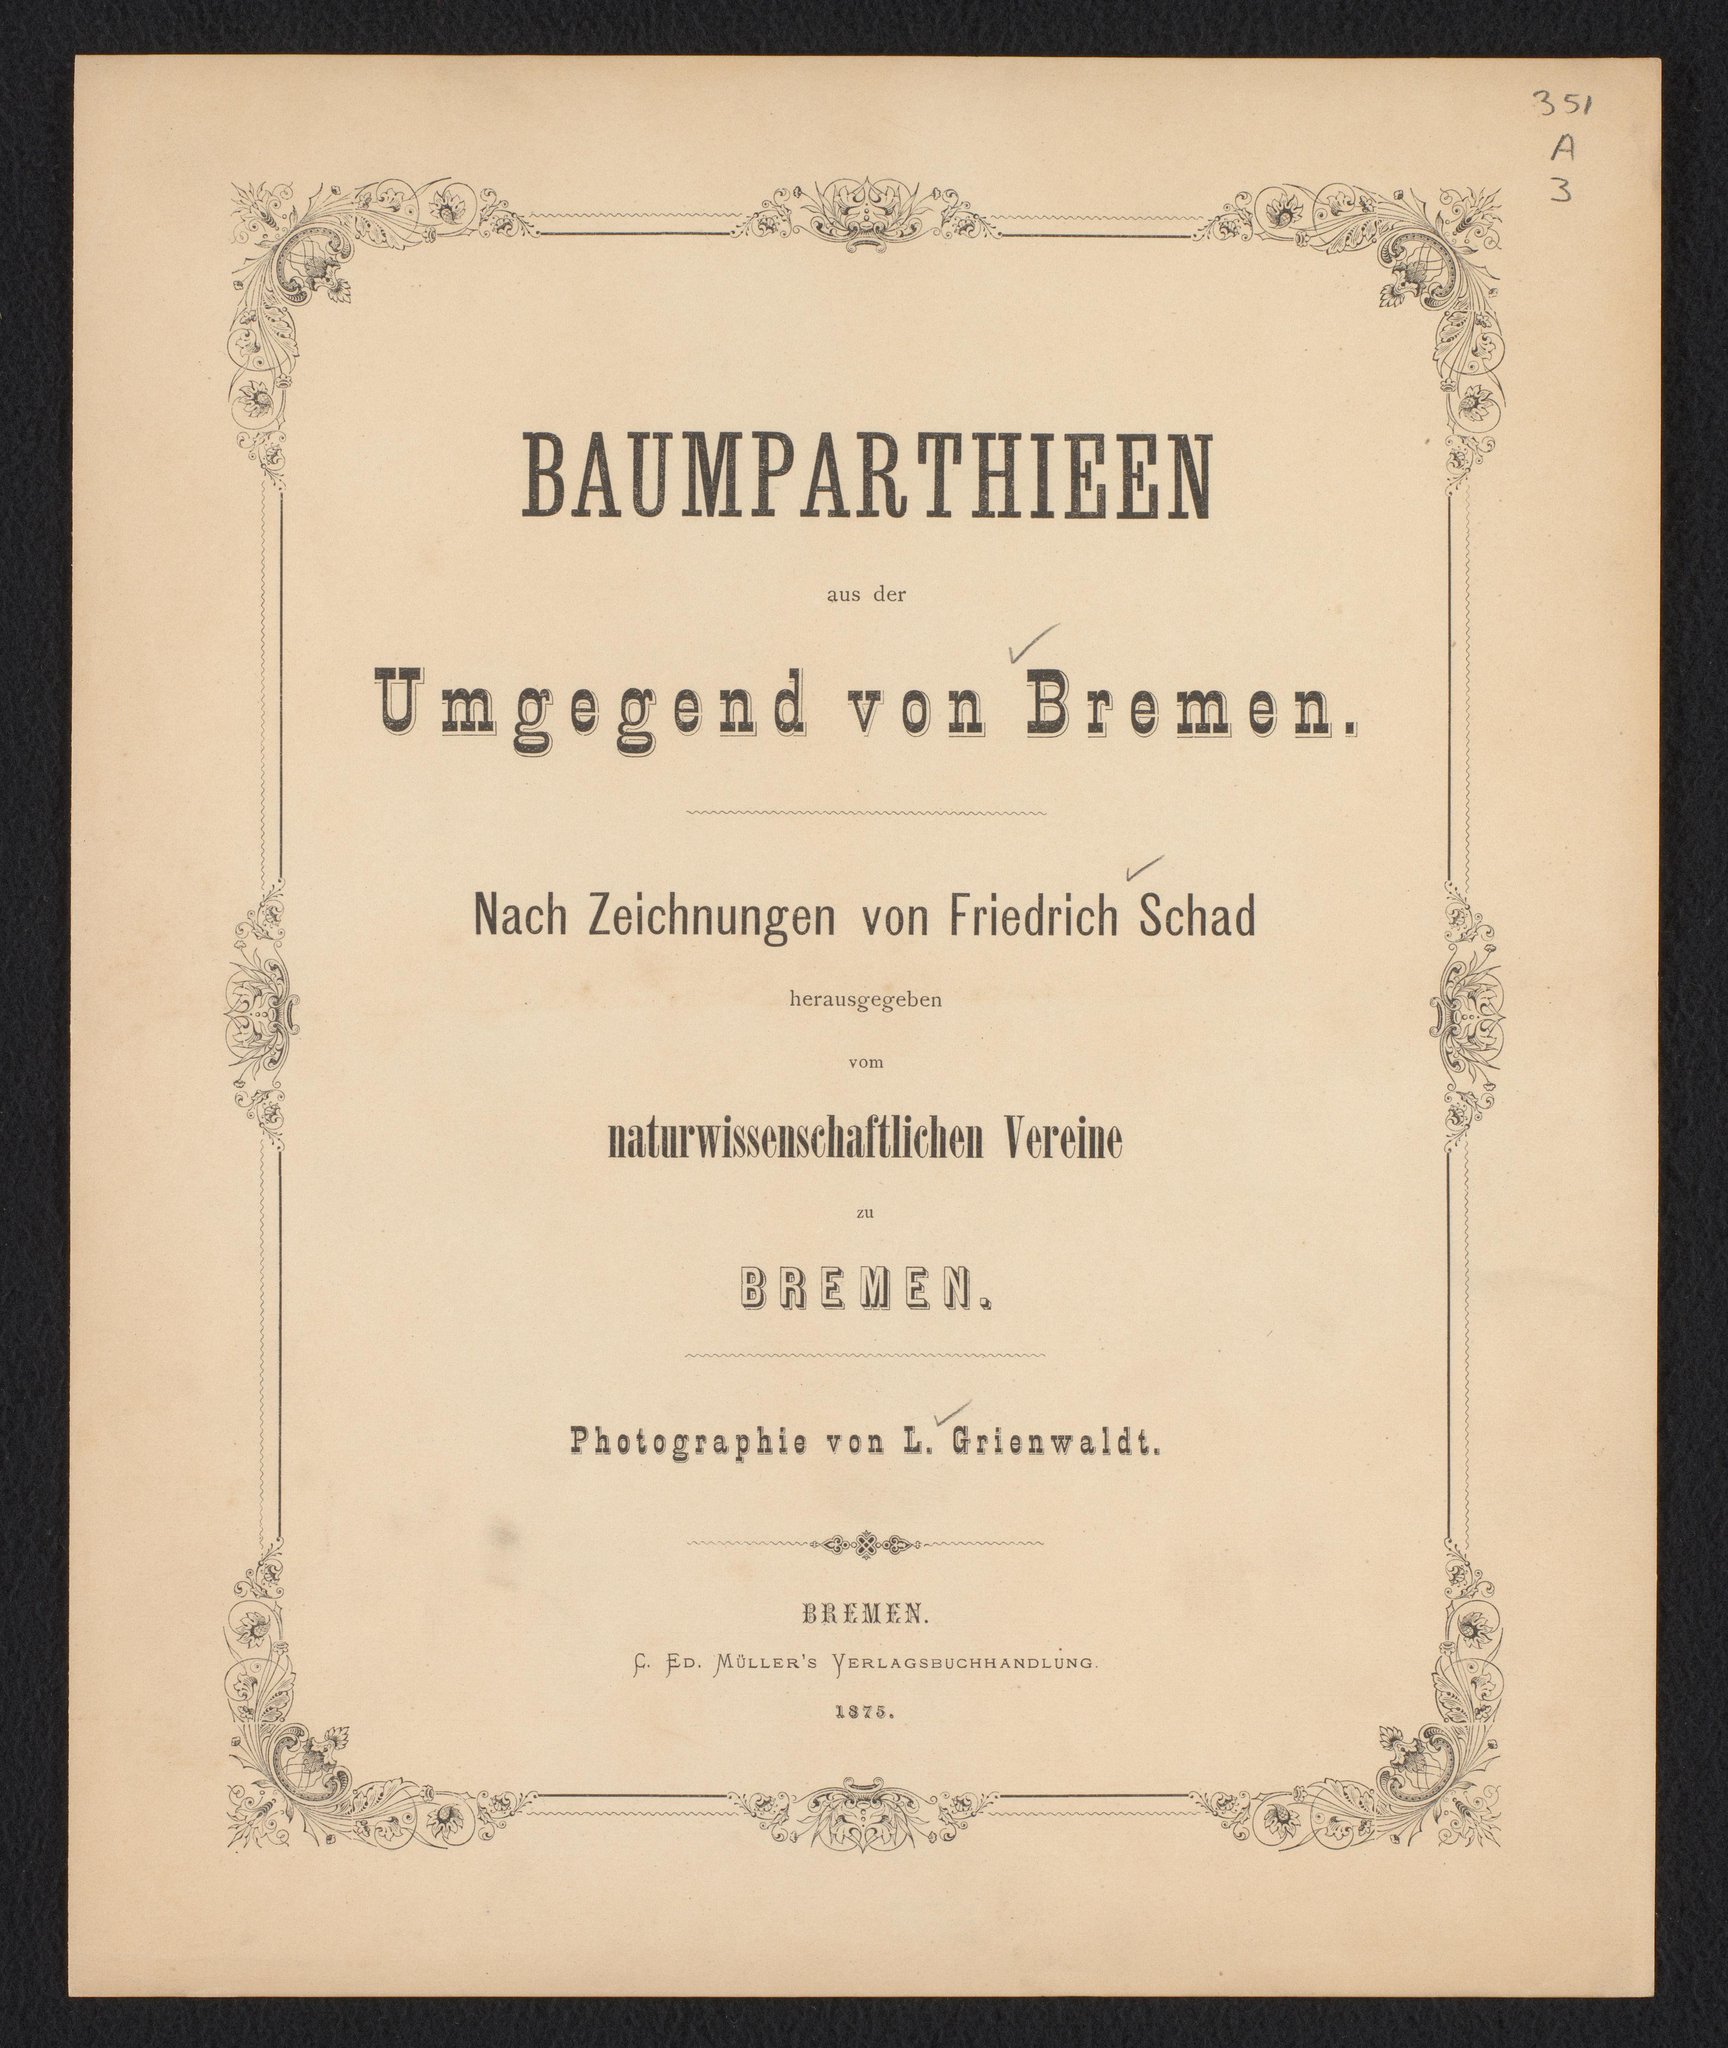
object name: wrapper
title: Baumparthieen aus der Umgegend von Bremen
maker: louis oskar grienwaldt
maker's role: fotograaf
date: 1875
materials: cardboard, leather, paper, textile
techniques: letterpress printing, moire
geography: bremen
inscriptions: inscription: ‘2-D’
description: Omslag met zestien foto's van tekeningen van bomen.